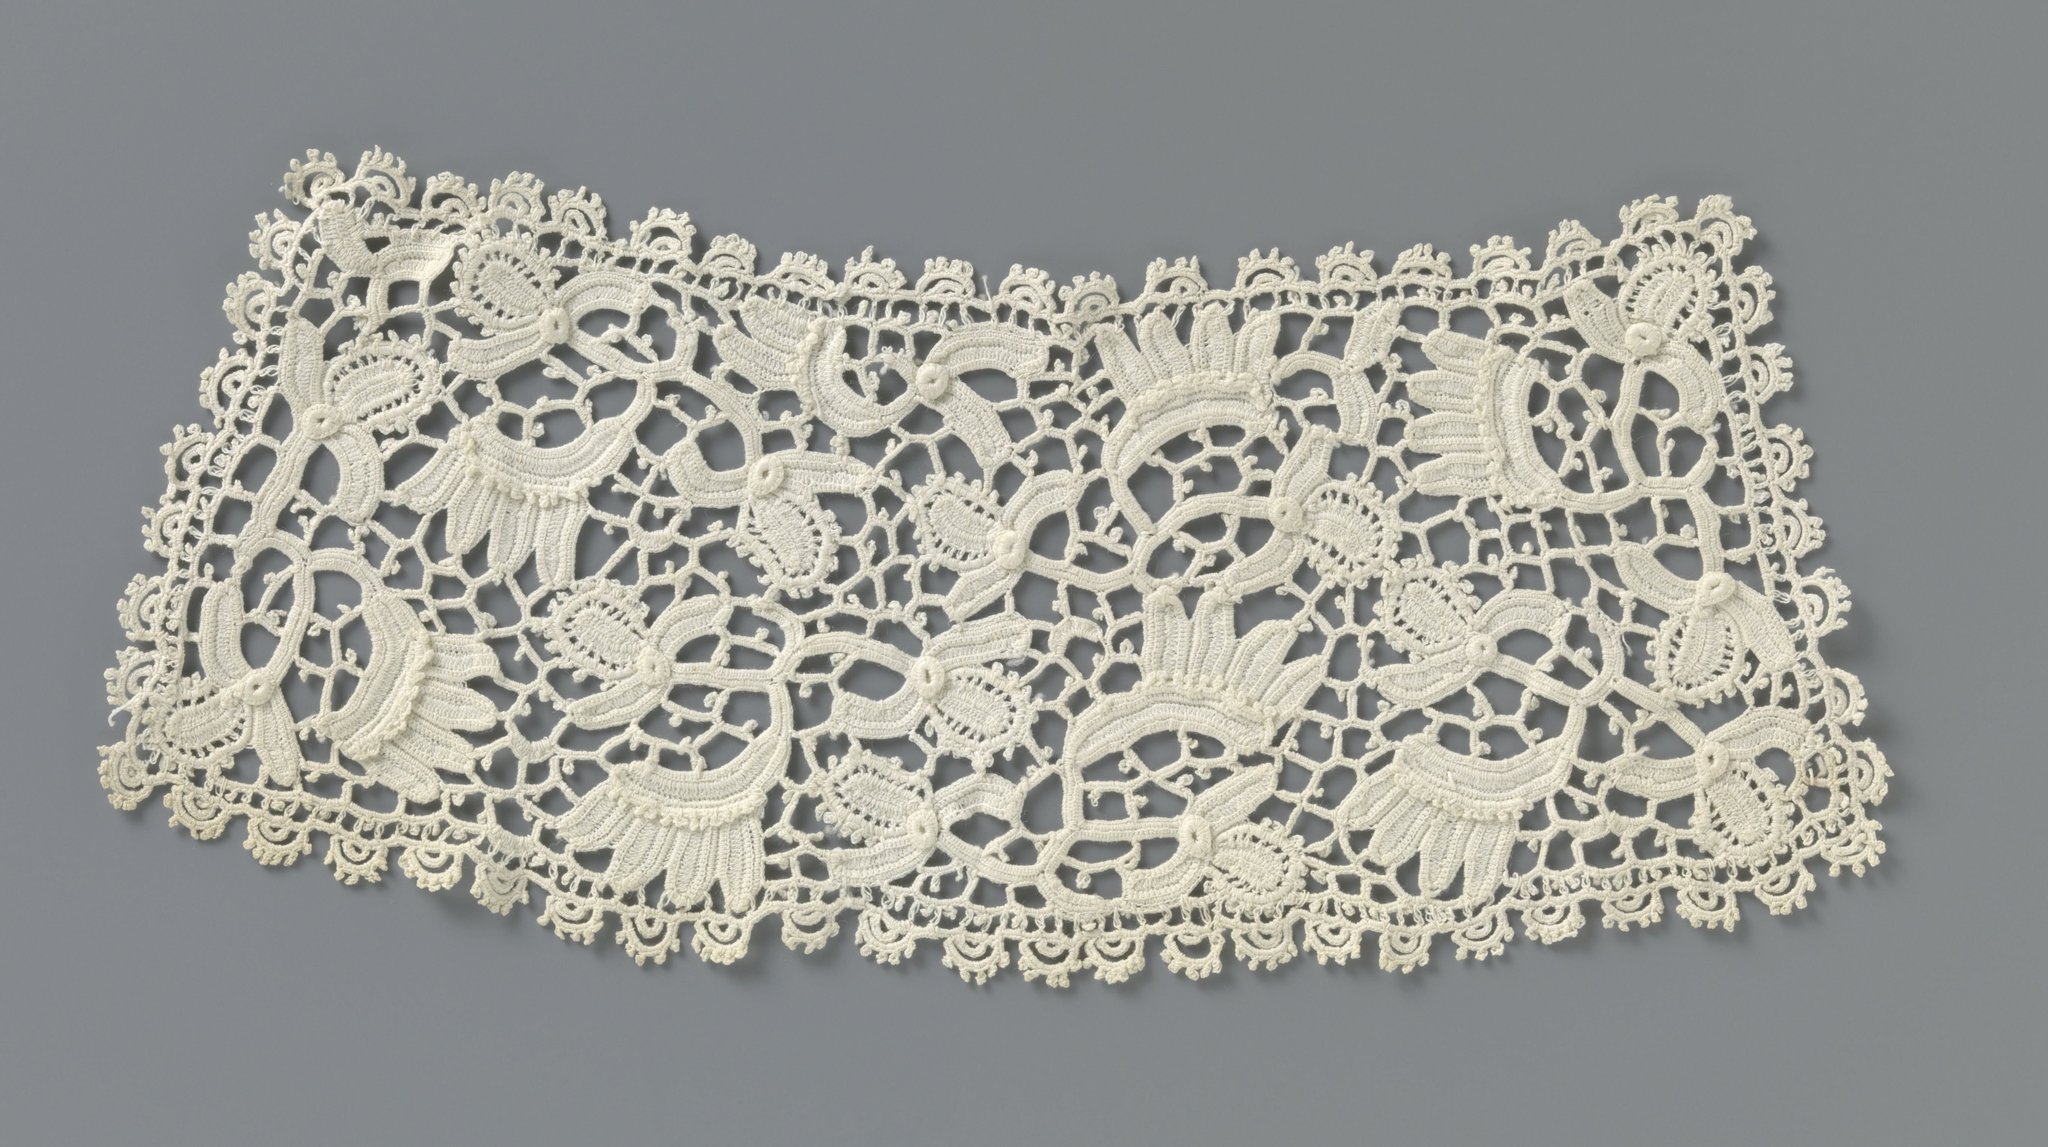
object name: cuff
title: Manchet van gehaakte kant met borstelachtige bladeren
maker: Anonymous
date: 1890-1909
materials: cotton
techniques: crocheted lace, irish crochet lace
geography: ireland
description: Het is een aanname dat deze Ierse gehaakte kant ook daadwerkelijk in Ierland is gemaakt. Ierse gehaakte kant kent zijn oorsprong rond 1760 en kwam vanaf 1840 in ontwikkeling. Aangezien volgens Martine Bruggeman (Kant in Europa) de Ierse haakindustrie aan het eind van de 19e eeuw gereorganiseerd werd en in populariteit groeide, is het hier beschreven stuk gedateerd rond 1890, tot 1909 vanwege de datering in het eerste decennium van populariteit van Ierse gehaakte kant volgens het Kantlexicon (Johan Coene).